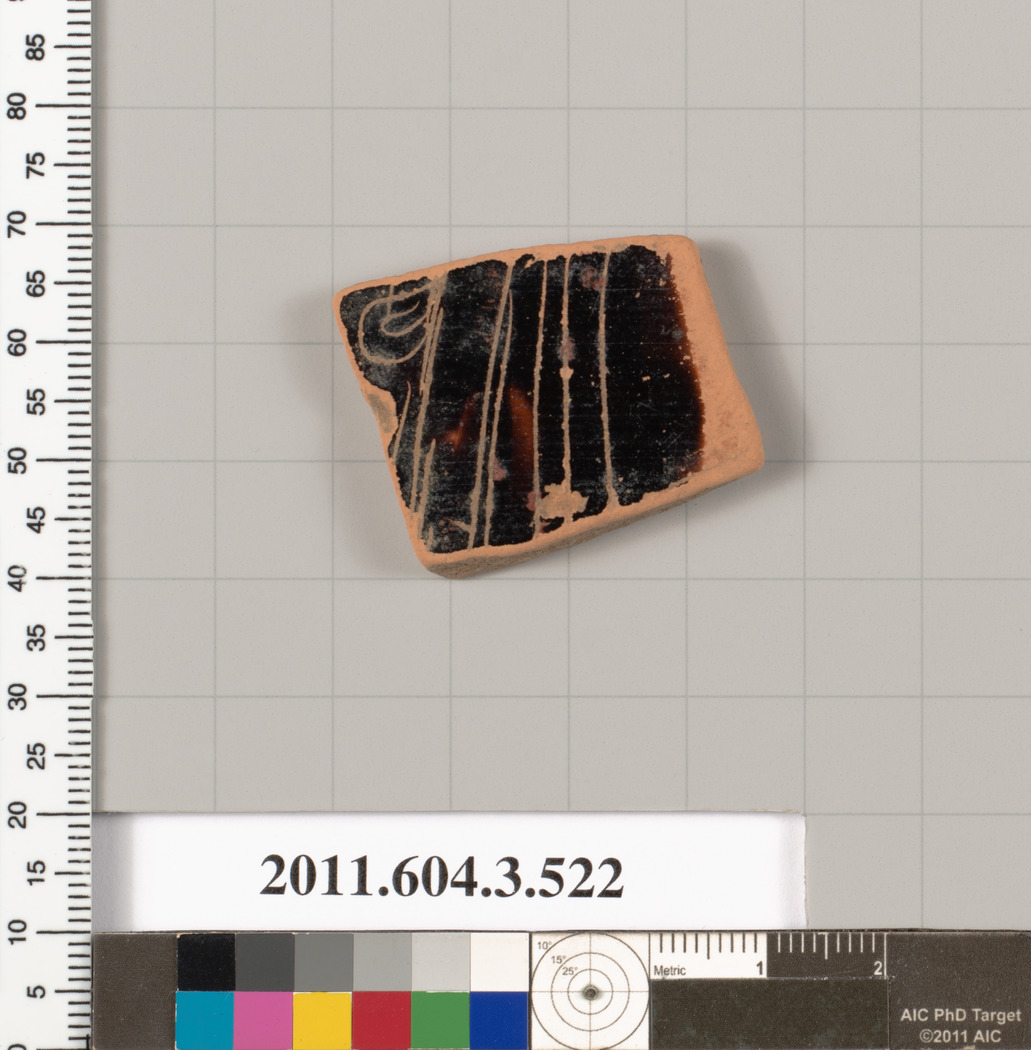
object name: column krater fragment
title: Terracotta fragment of a column-krater (bowl for mixing wine and water)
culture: greek, attic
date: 567-535 BCE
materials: terracotta